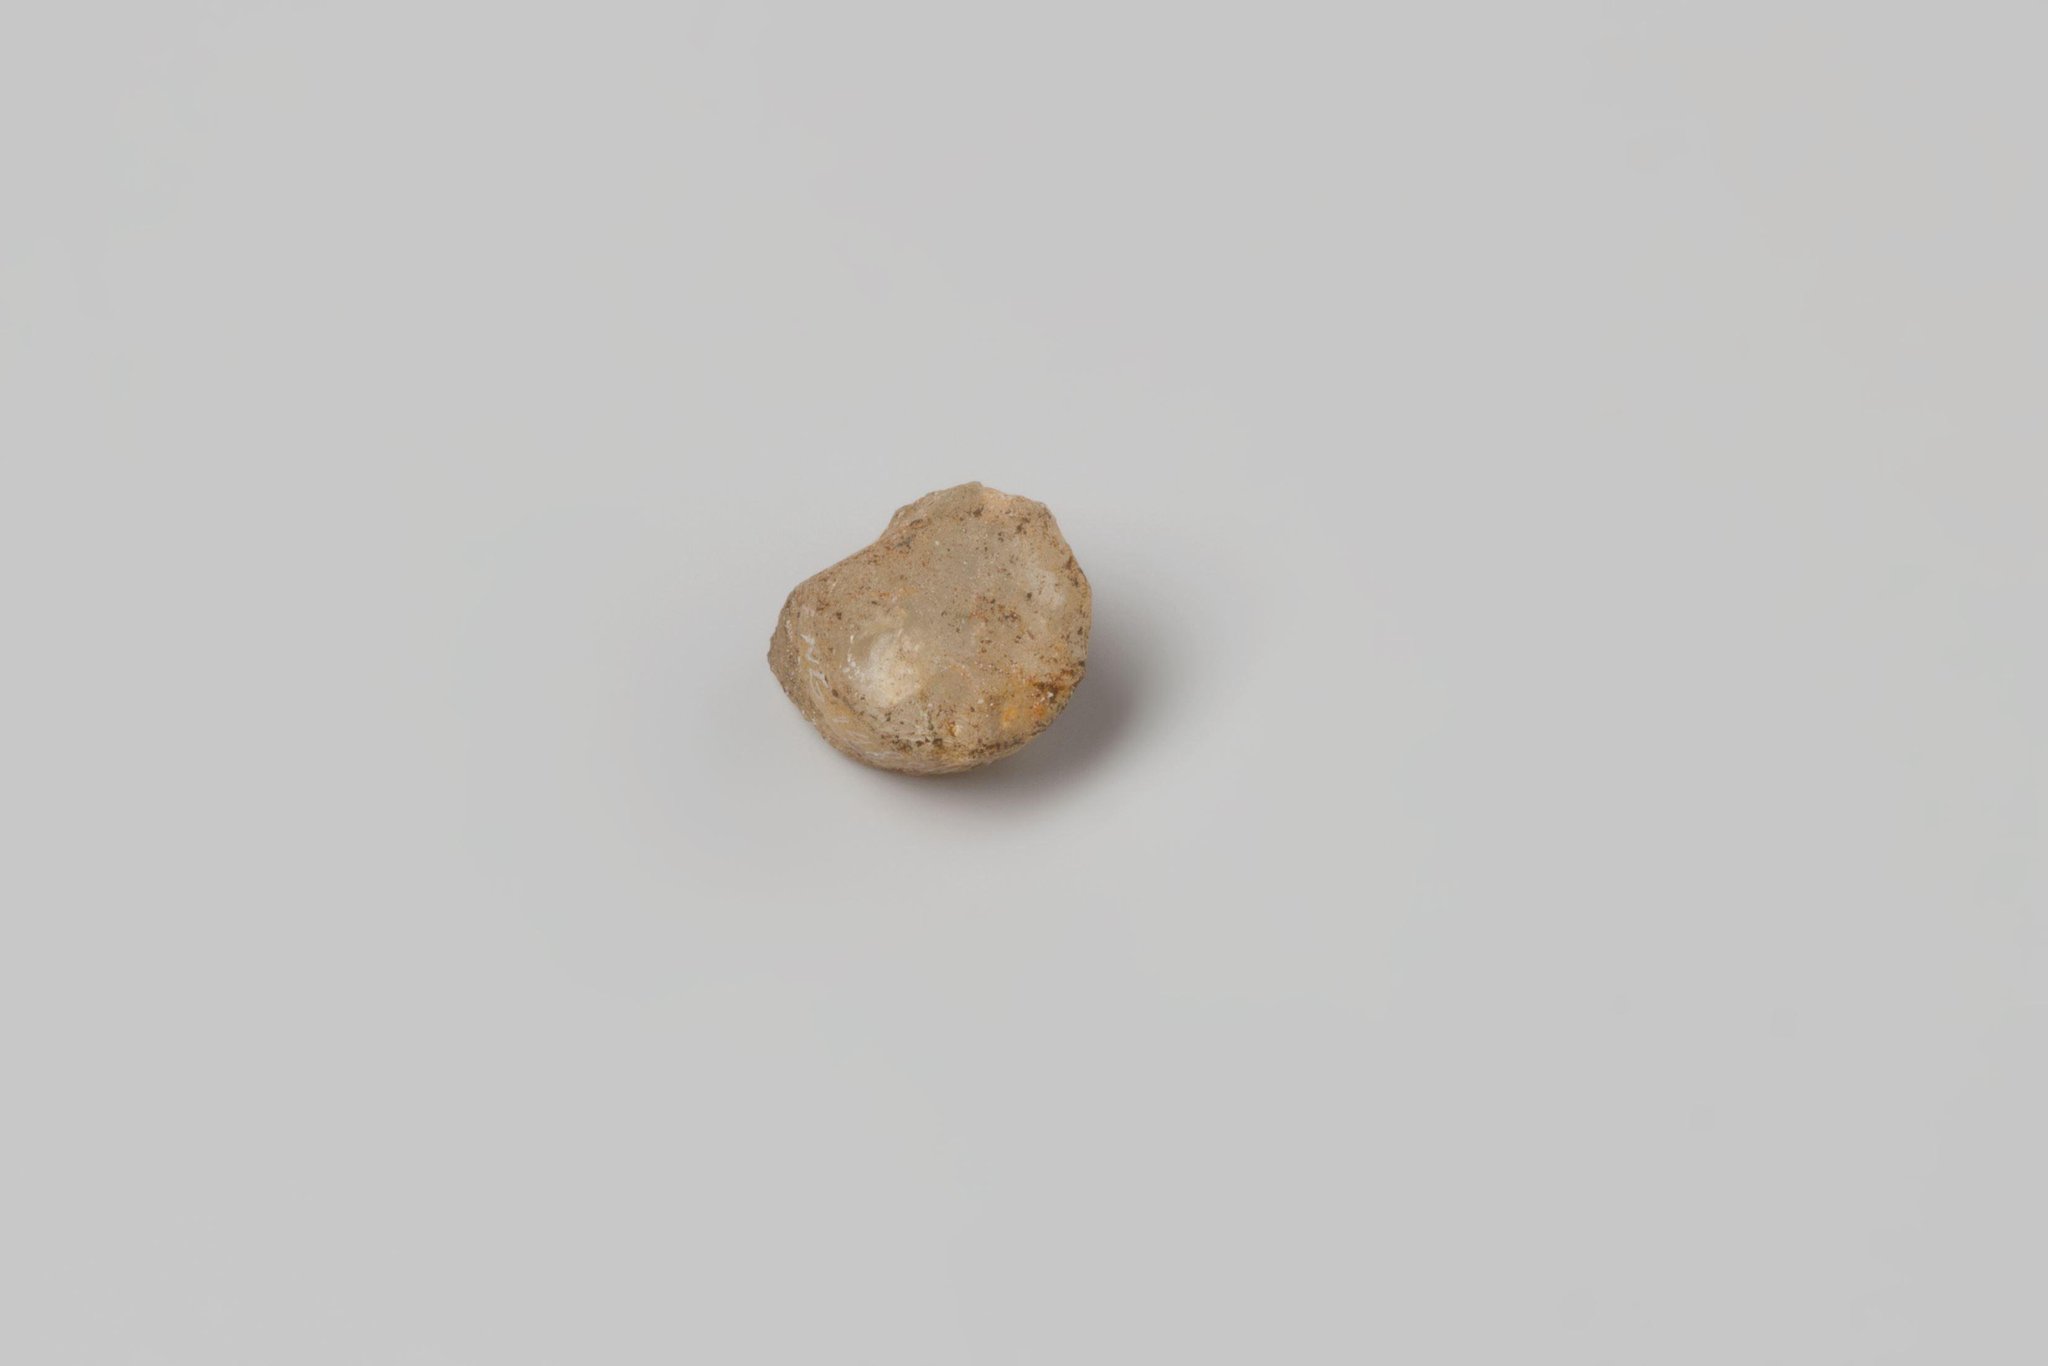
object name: helve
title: Fragment rechte steel van glas uit het wrak van de Oost-Indiëvaarder Hollandia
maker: Anonymous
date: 1700-1743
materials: glass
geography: netherlands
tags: verenigde oostindische compagnie, hollandia (schip), annet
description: Glass, stem glass, stems, plain; fragm, circular, hollow core, eroded